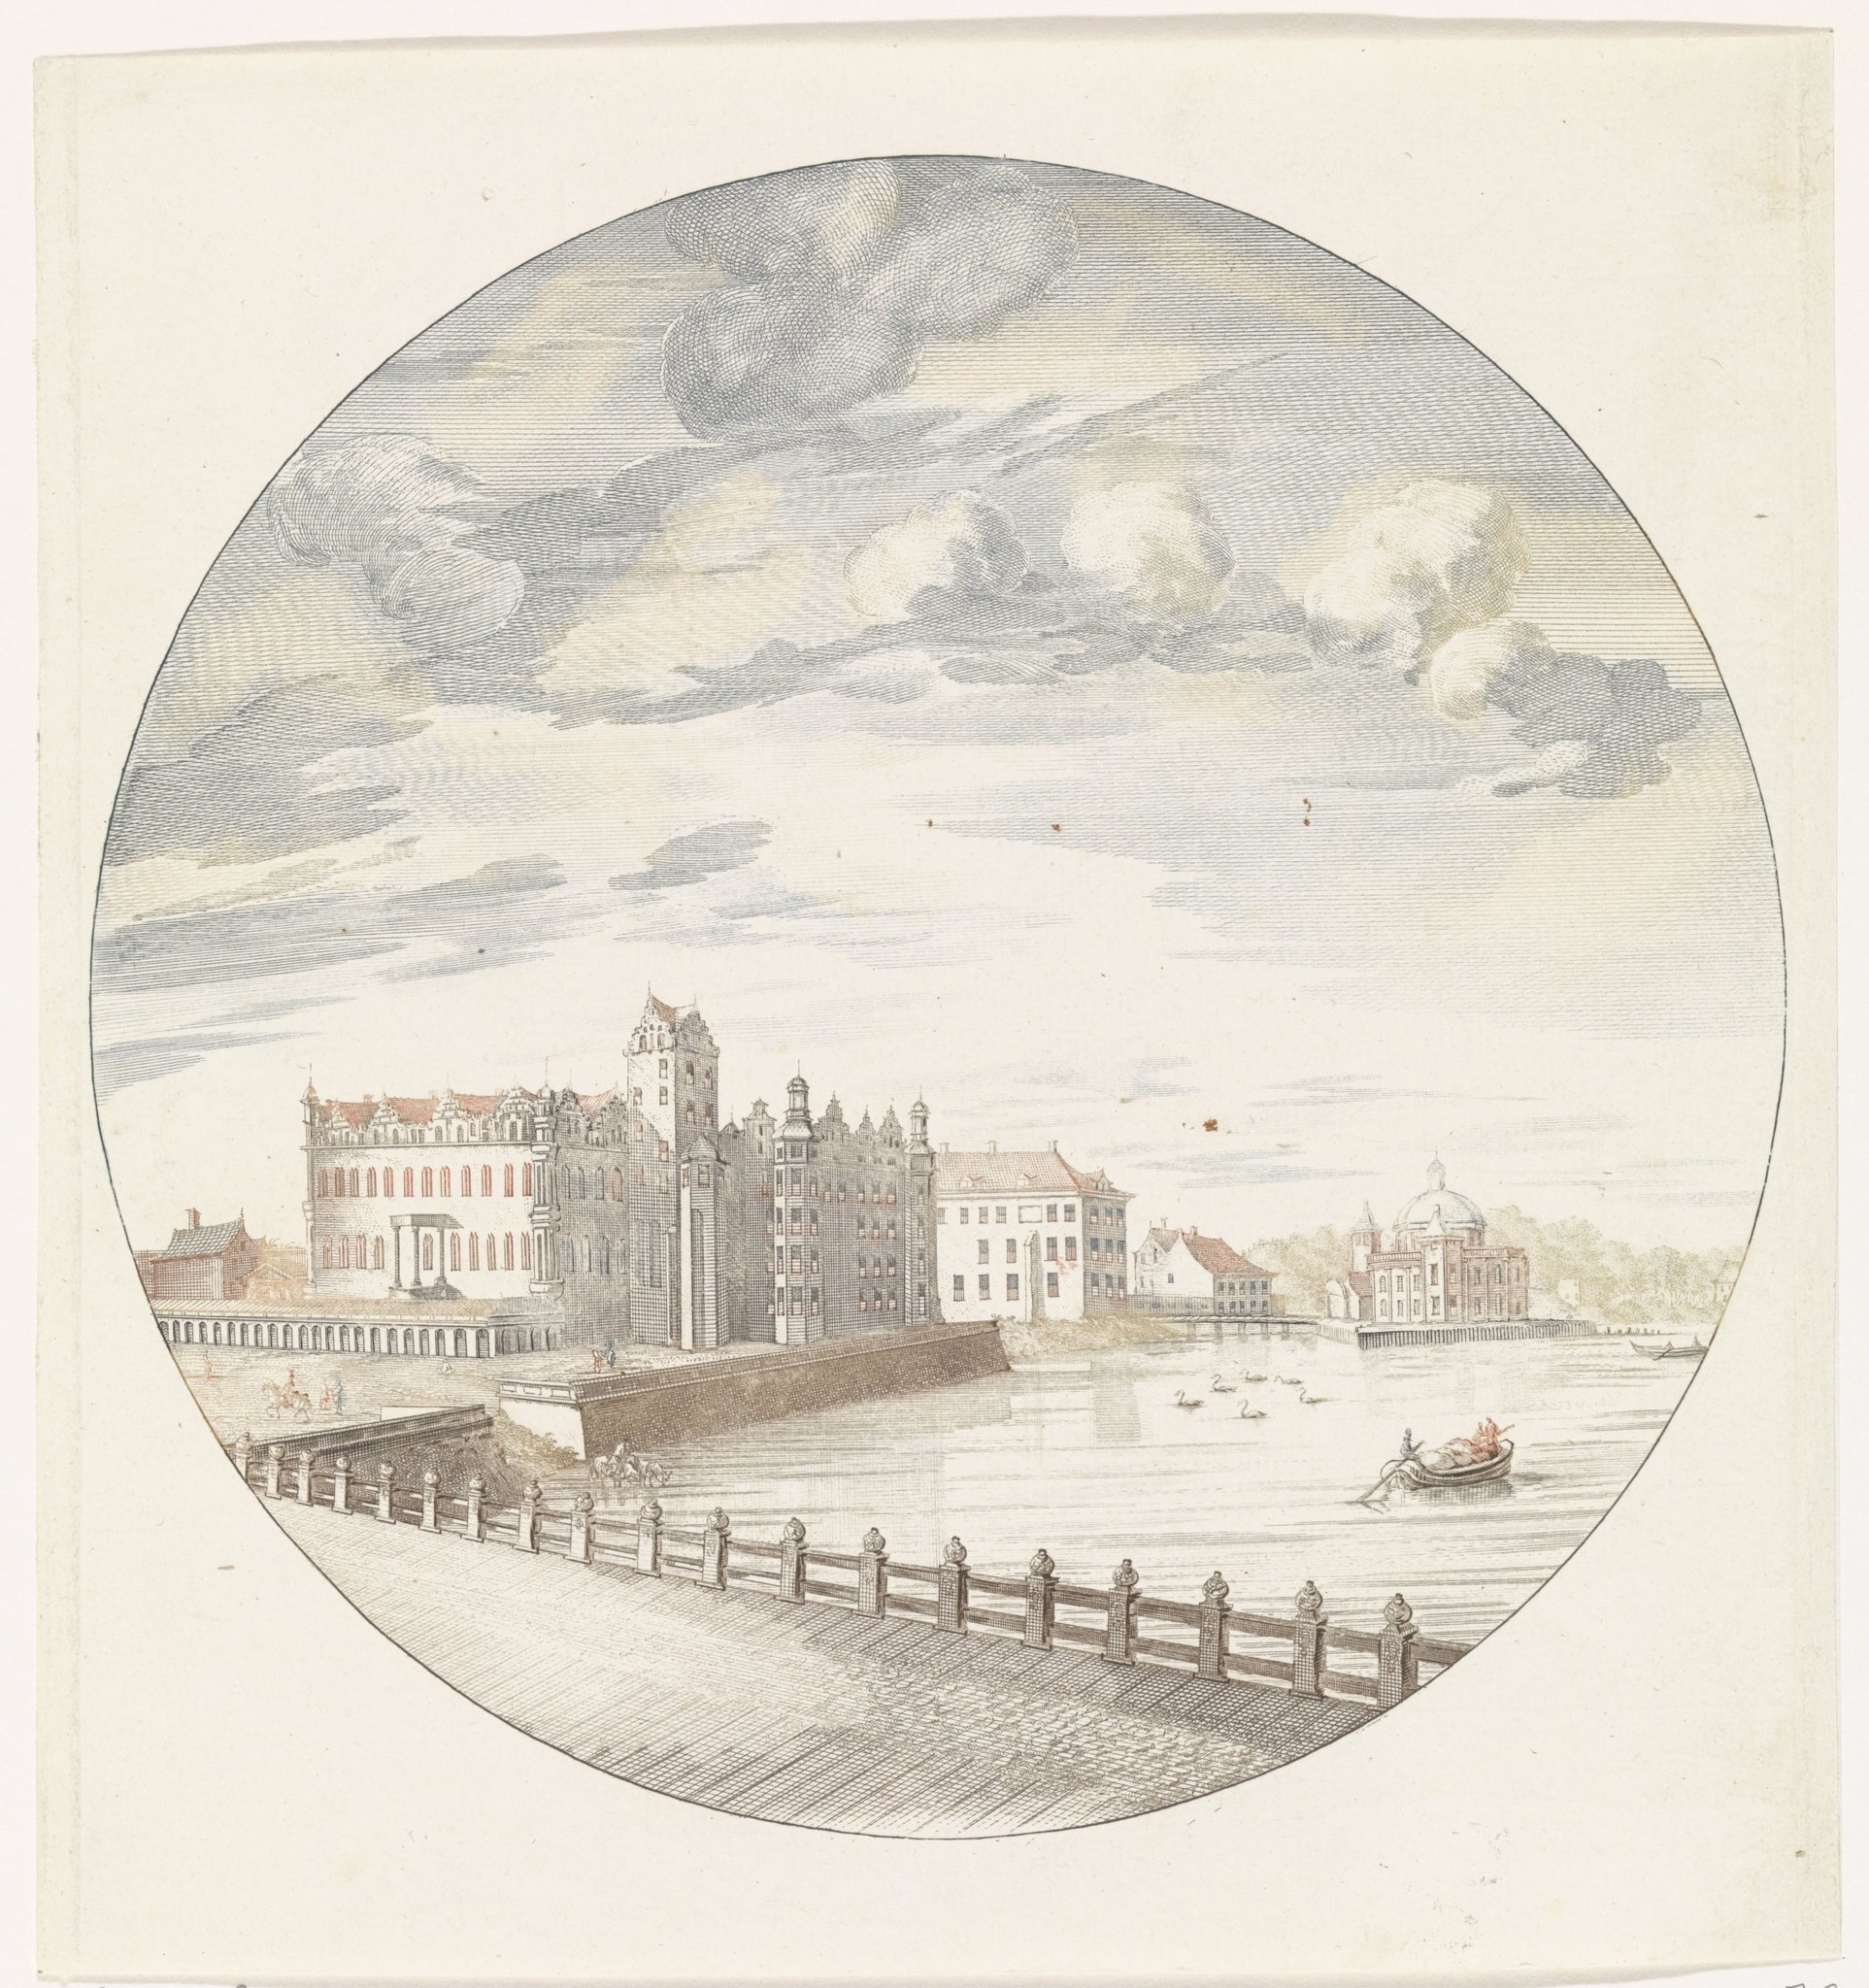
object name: print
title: Gezicht op het stadsslot van Berlijn aan de rivierzijde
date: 1688-1698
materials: paper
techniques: etching, lithography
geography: netherlands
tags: castle, river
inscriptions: collector's mark: Lugt 2760, collector's mark: Lugt 2228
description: Gezicht op het stadsslot van Berlijn aan de rivier de Spree. Op de rivier vaart een roeiboot.